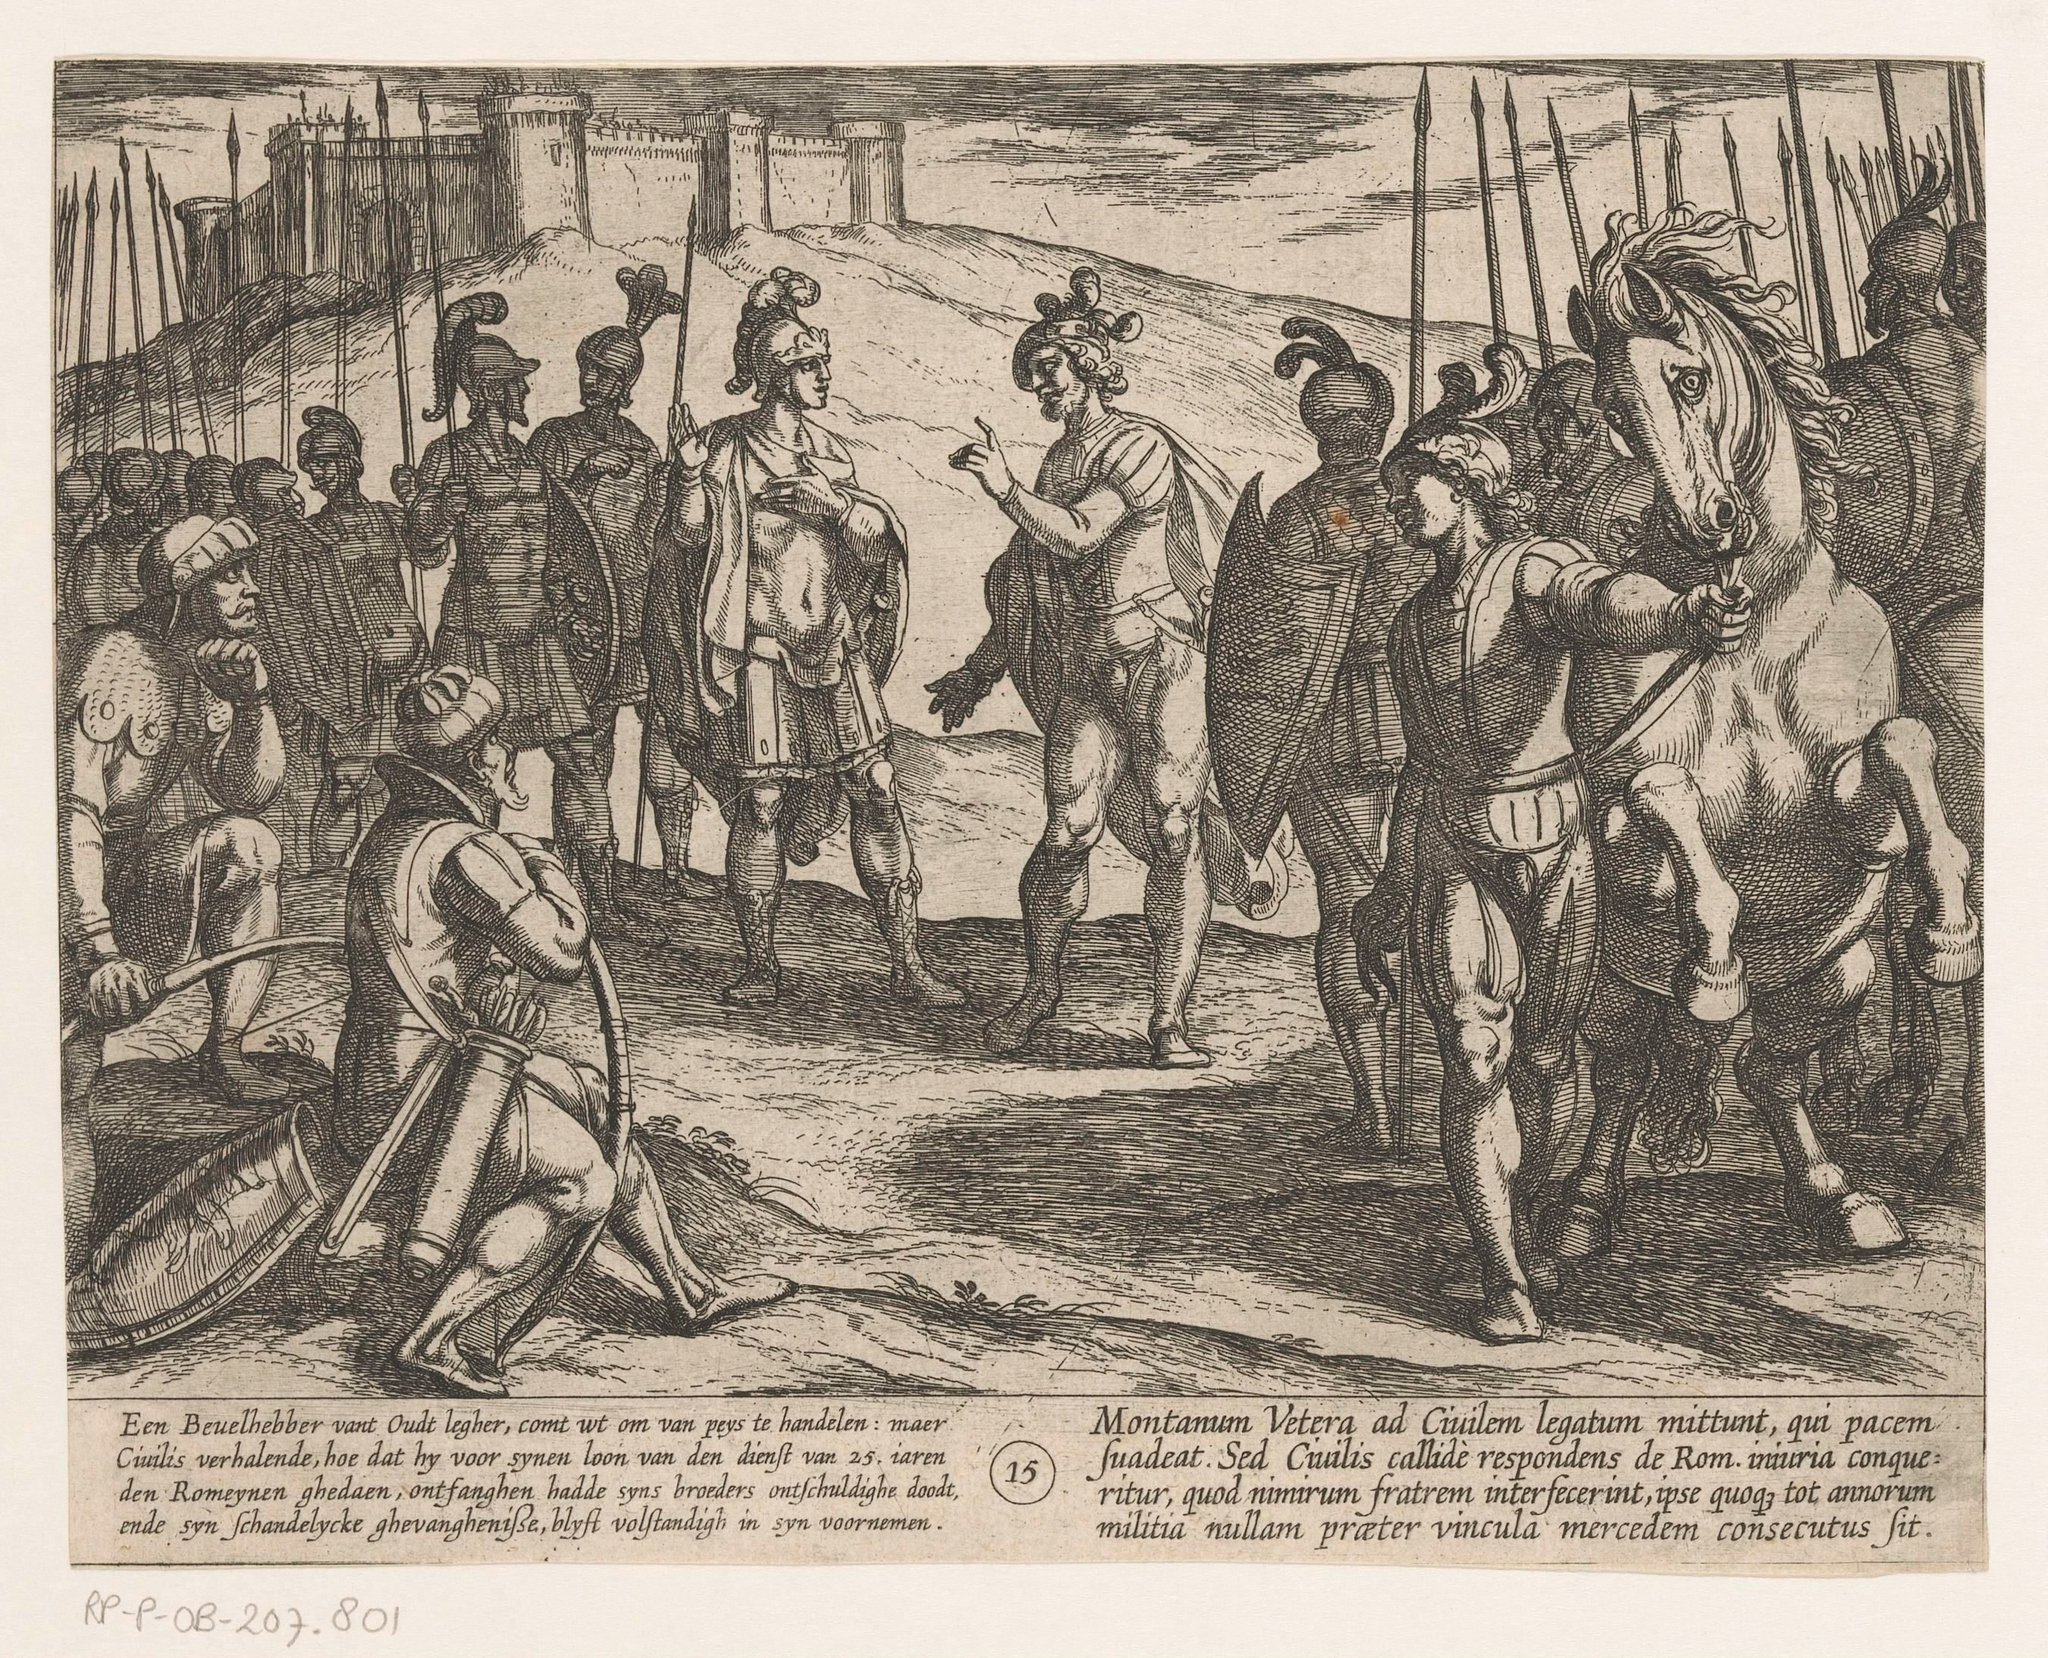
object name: print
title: Batavorum cum Romanis Bellum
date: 1611-1612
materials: paper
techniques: etching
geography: italy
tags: commander-in-chief, general, marshal, the soldier; the soldier's life, negotiations between combatants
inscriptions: collector's mark: Lugt 2228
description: Deze prent maakt deel uit van een reeks van 36 prenten (+ titelpagina) over de oorlogen tussen de Romeinen en de Bataven.